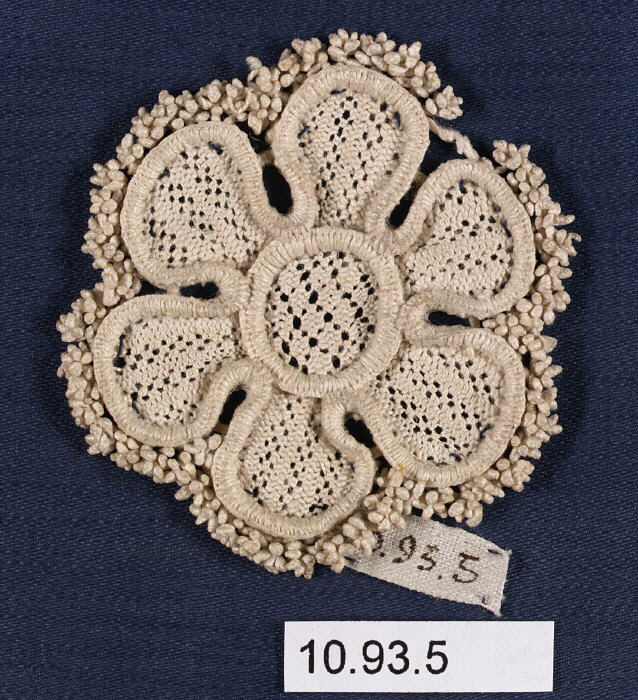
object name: rosace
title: Rosace (one of five)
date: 1701-1800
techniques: lace